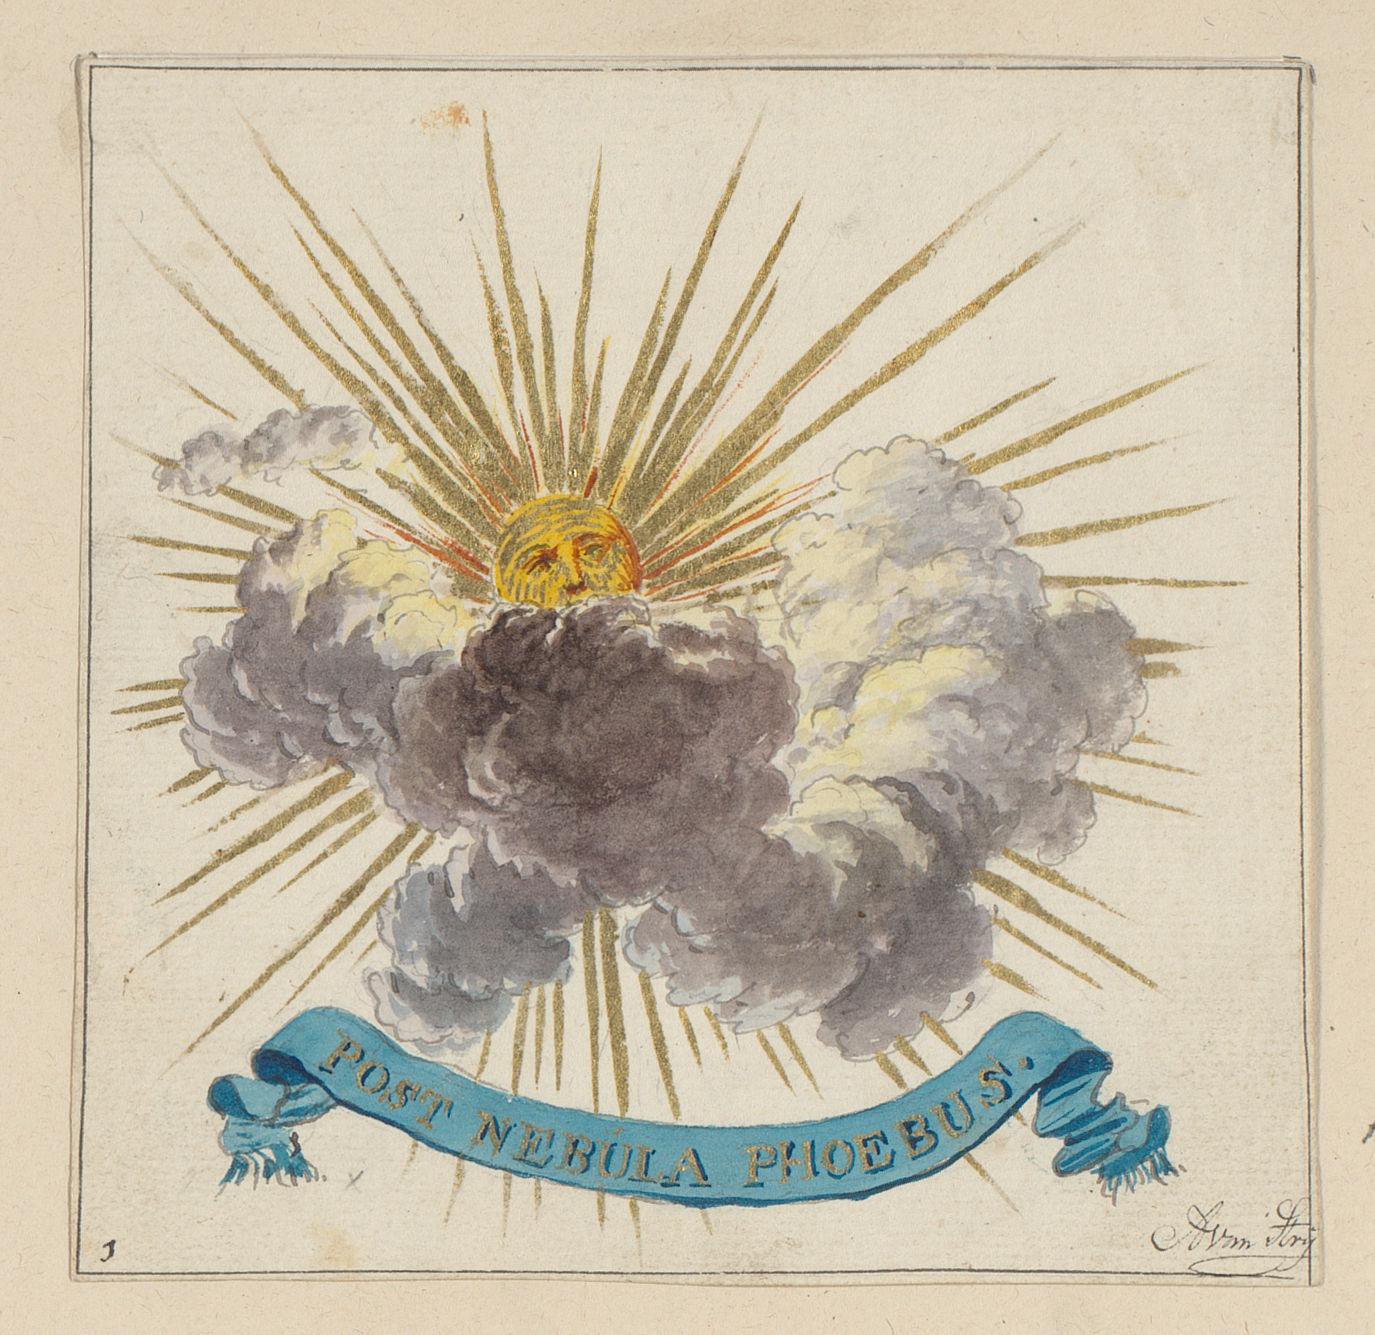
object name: album leaf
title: Post nebula phoebus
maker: abraham van strij (i)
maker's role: draughtsman, painter, print maker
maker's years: 1753-1826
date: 1763-1826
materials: paint, paper, pencil, watercolor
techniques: brush, pen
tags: clouds, sun as celestial body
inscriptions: collector's mark: Lugt 2228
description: De tekeningen van Abraham van Strij zijn op een later moment ingevoegd in het album met tekeningen van Jurriaan Andriessen.